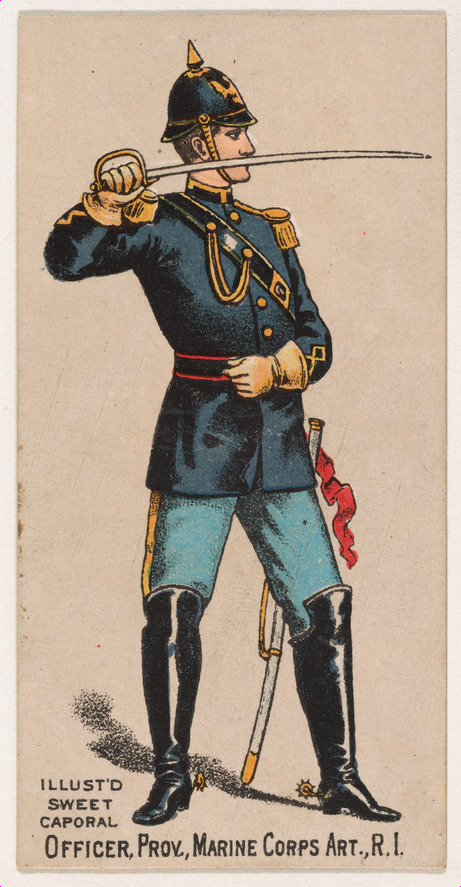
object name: print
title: Officer, Providence Marine Corps Artillery, Rhode Island, from the Military Series (N224) issued by Kinney Tobacco Company to promote Sweet Caporal Cigarettes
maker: kinney brothers tobacco company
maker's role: publisher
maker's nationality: american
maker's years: 1869-2011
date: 1888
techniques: color lithograph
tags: military,swords,men,profiles